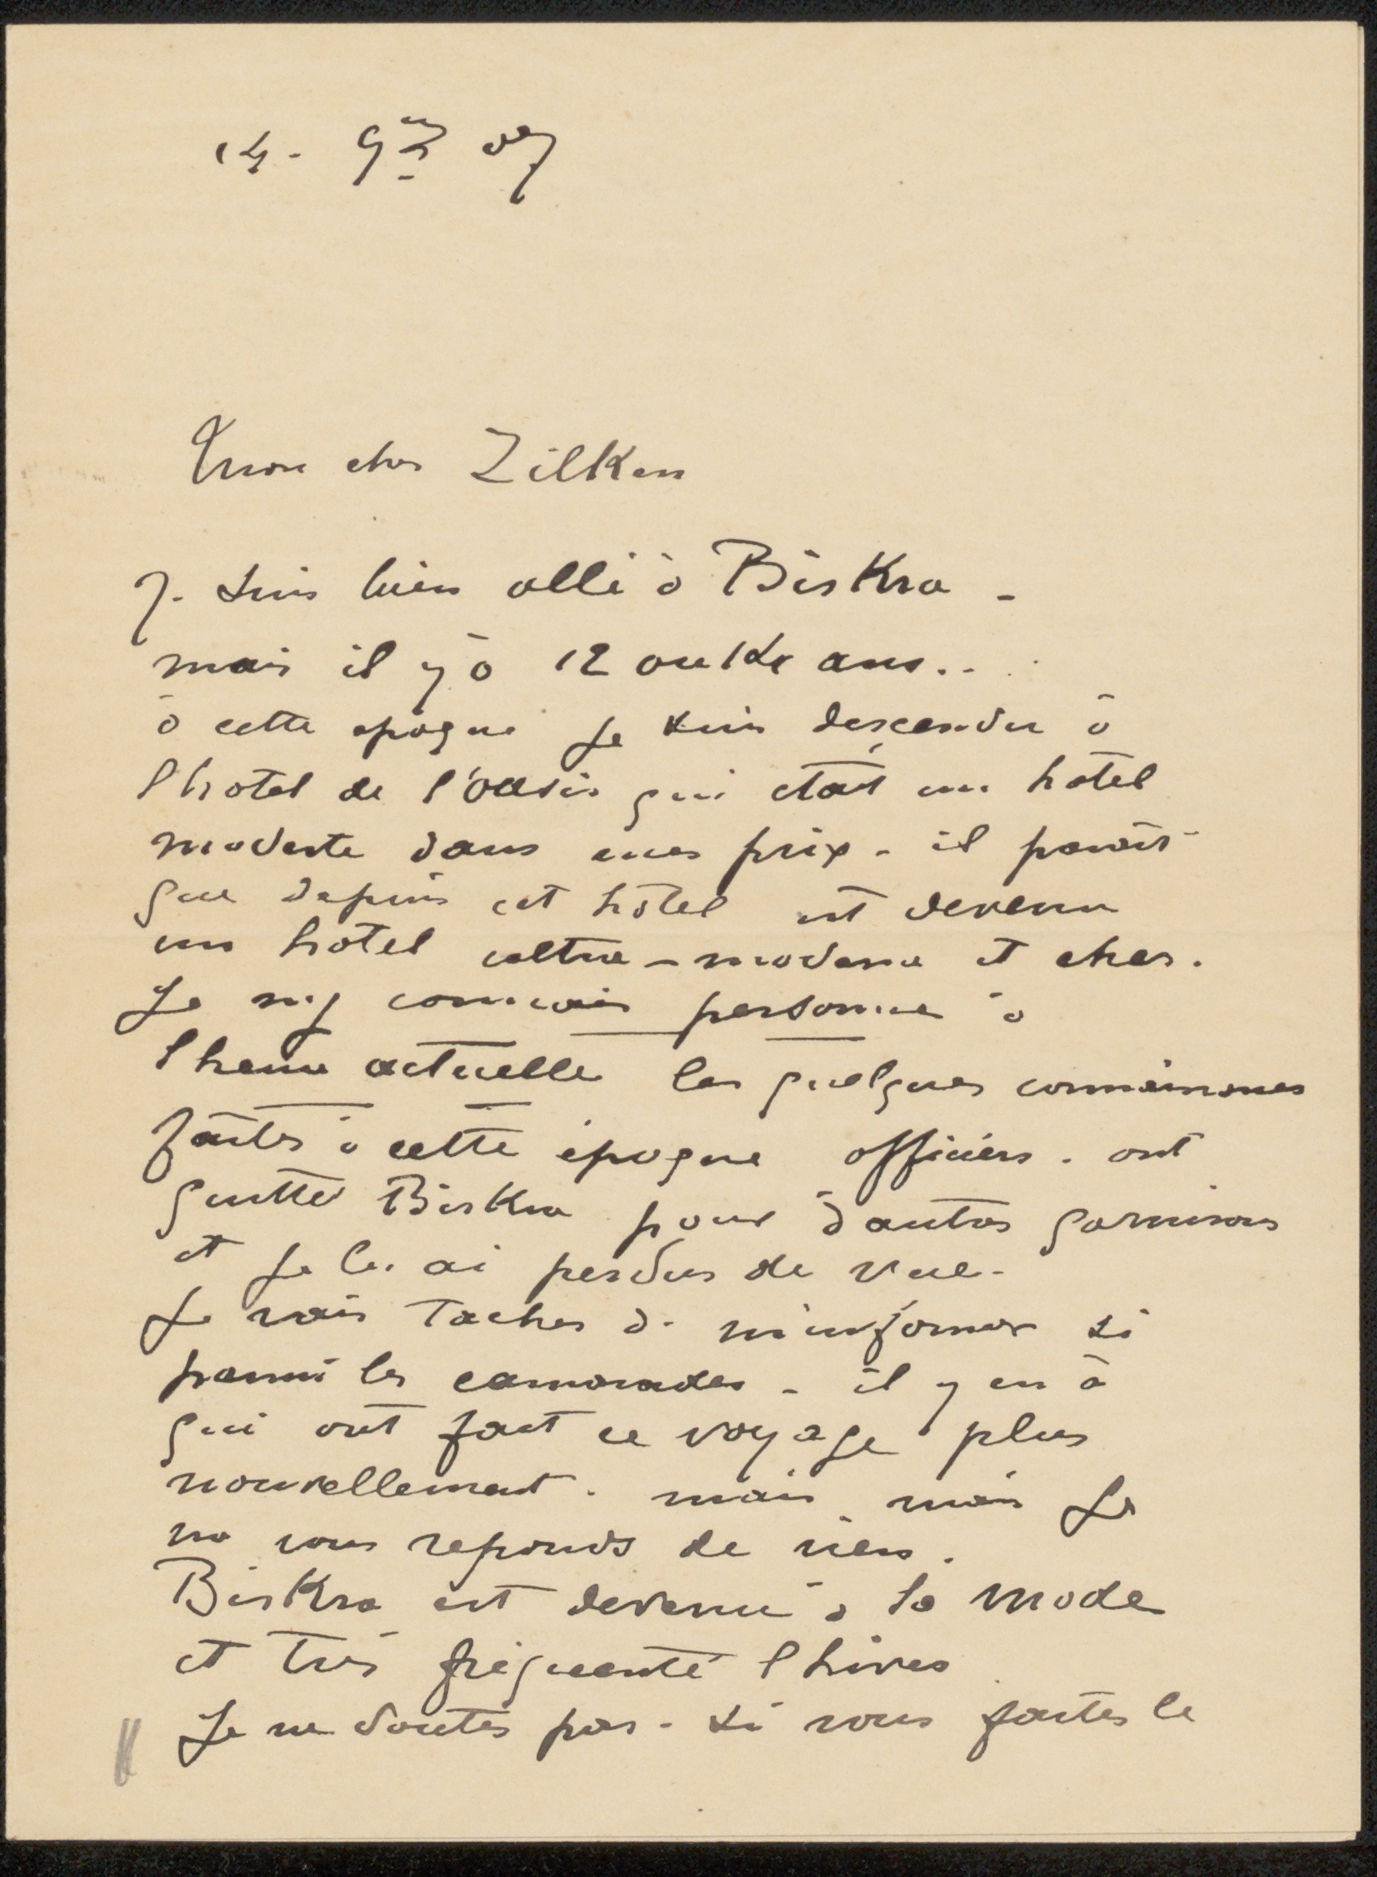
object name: letter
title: Brief aan Philip Zilcken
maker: henri pierre paillard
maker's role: painter, print maker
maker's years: 1844-1912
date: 1907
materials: ink, paper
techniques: pen, writing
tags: draughtsman, philip zilcken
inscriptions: collector's mark: ‘RPK’